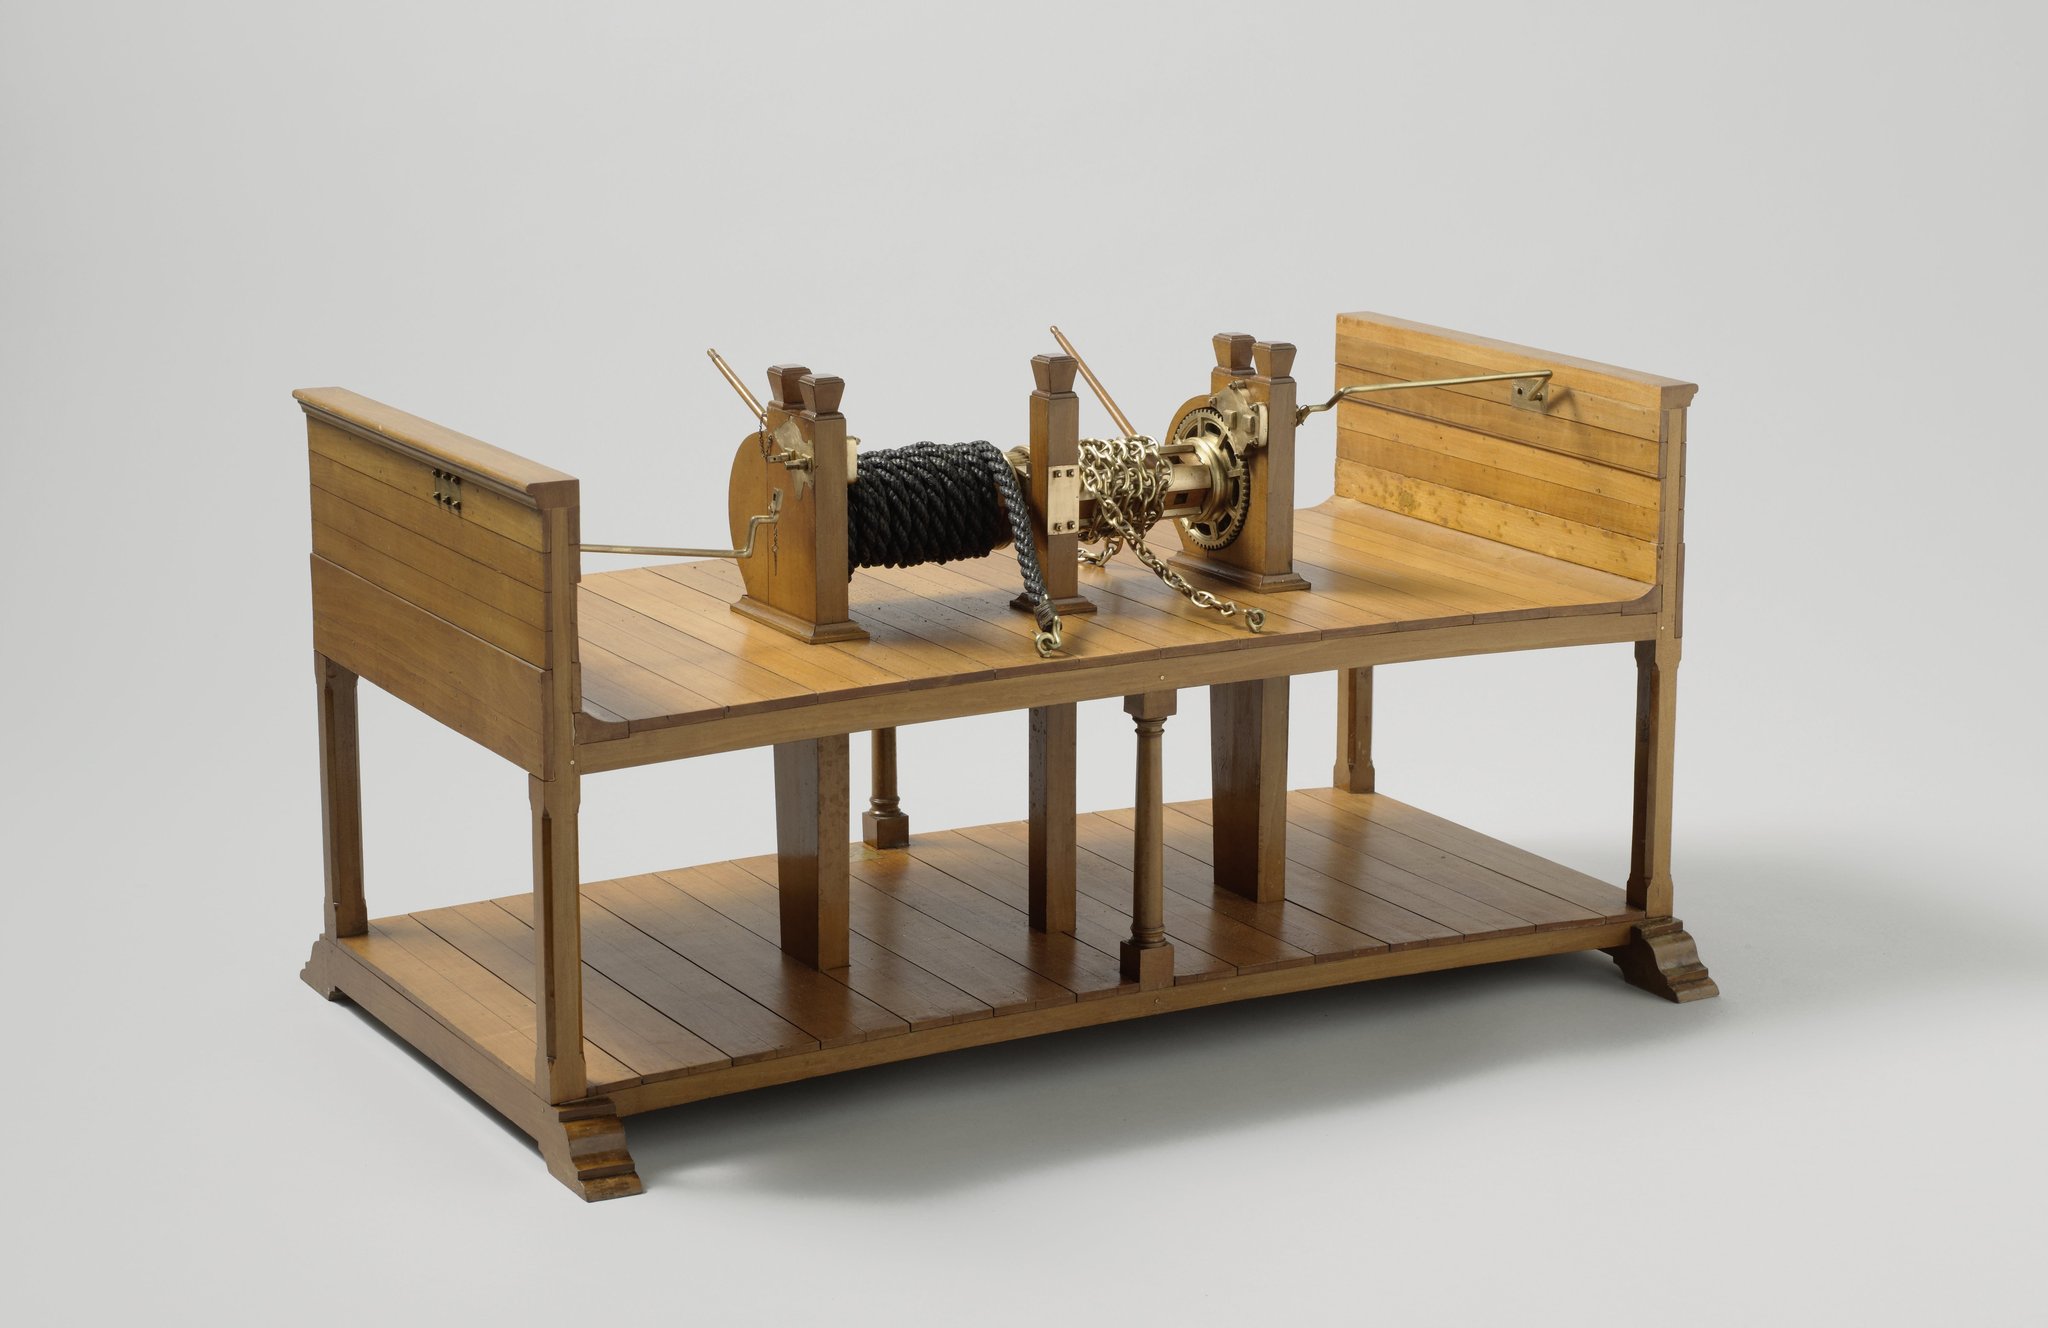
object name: demonstration model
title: Model of a Windlass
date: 1836-1837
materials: brass, iron, fiber, wood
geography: amsterdam